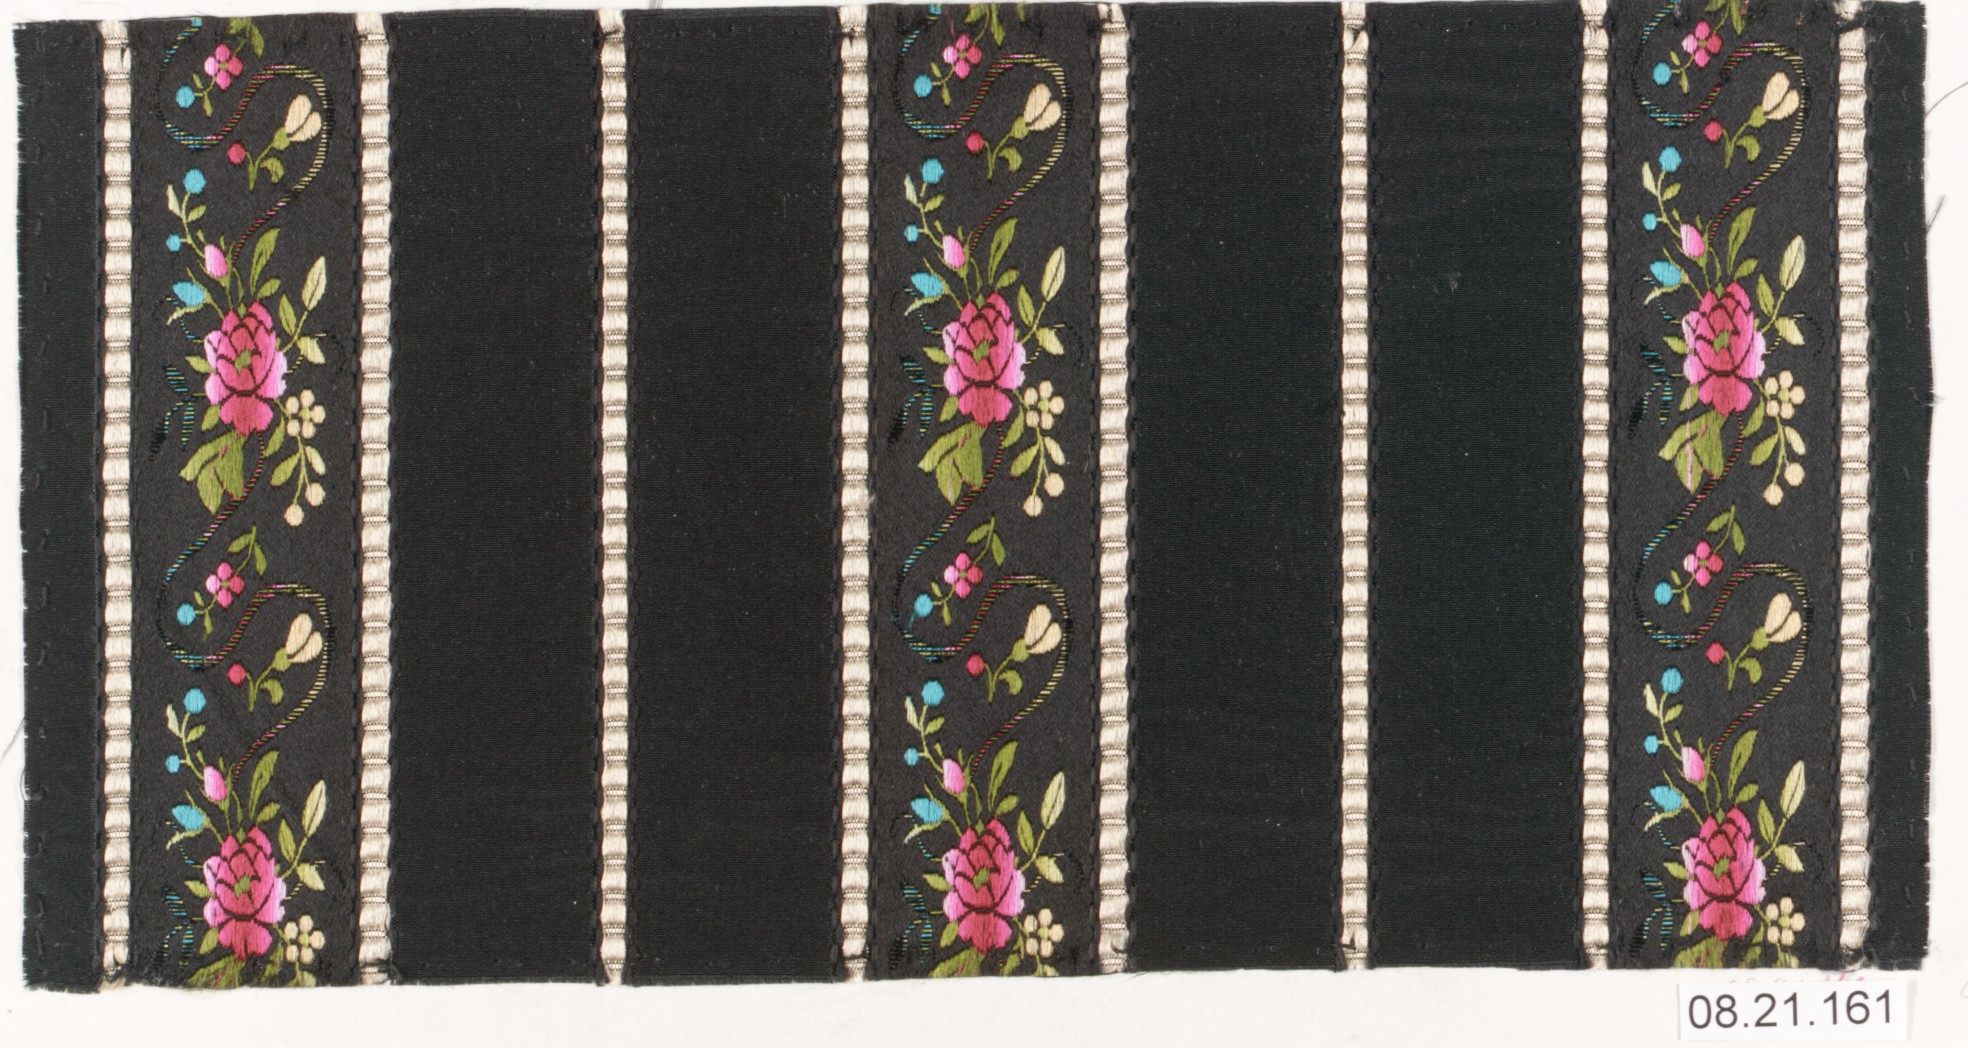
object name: textile sample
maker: Anonymous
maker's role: designer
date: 1900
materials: silk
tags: flowers